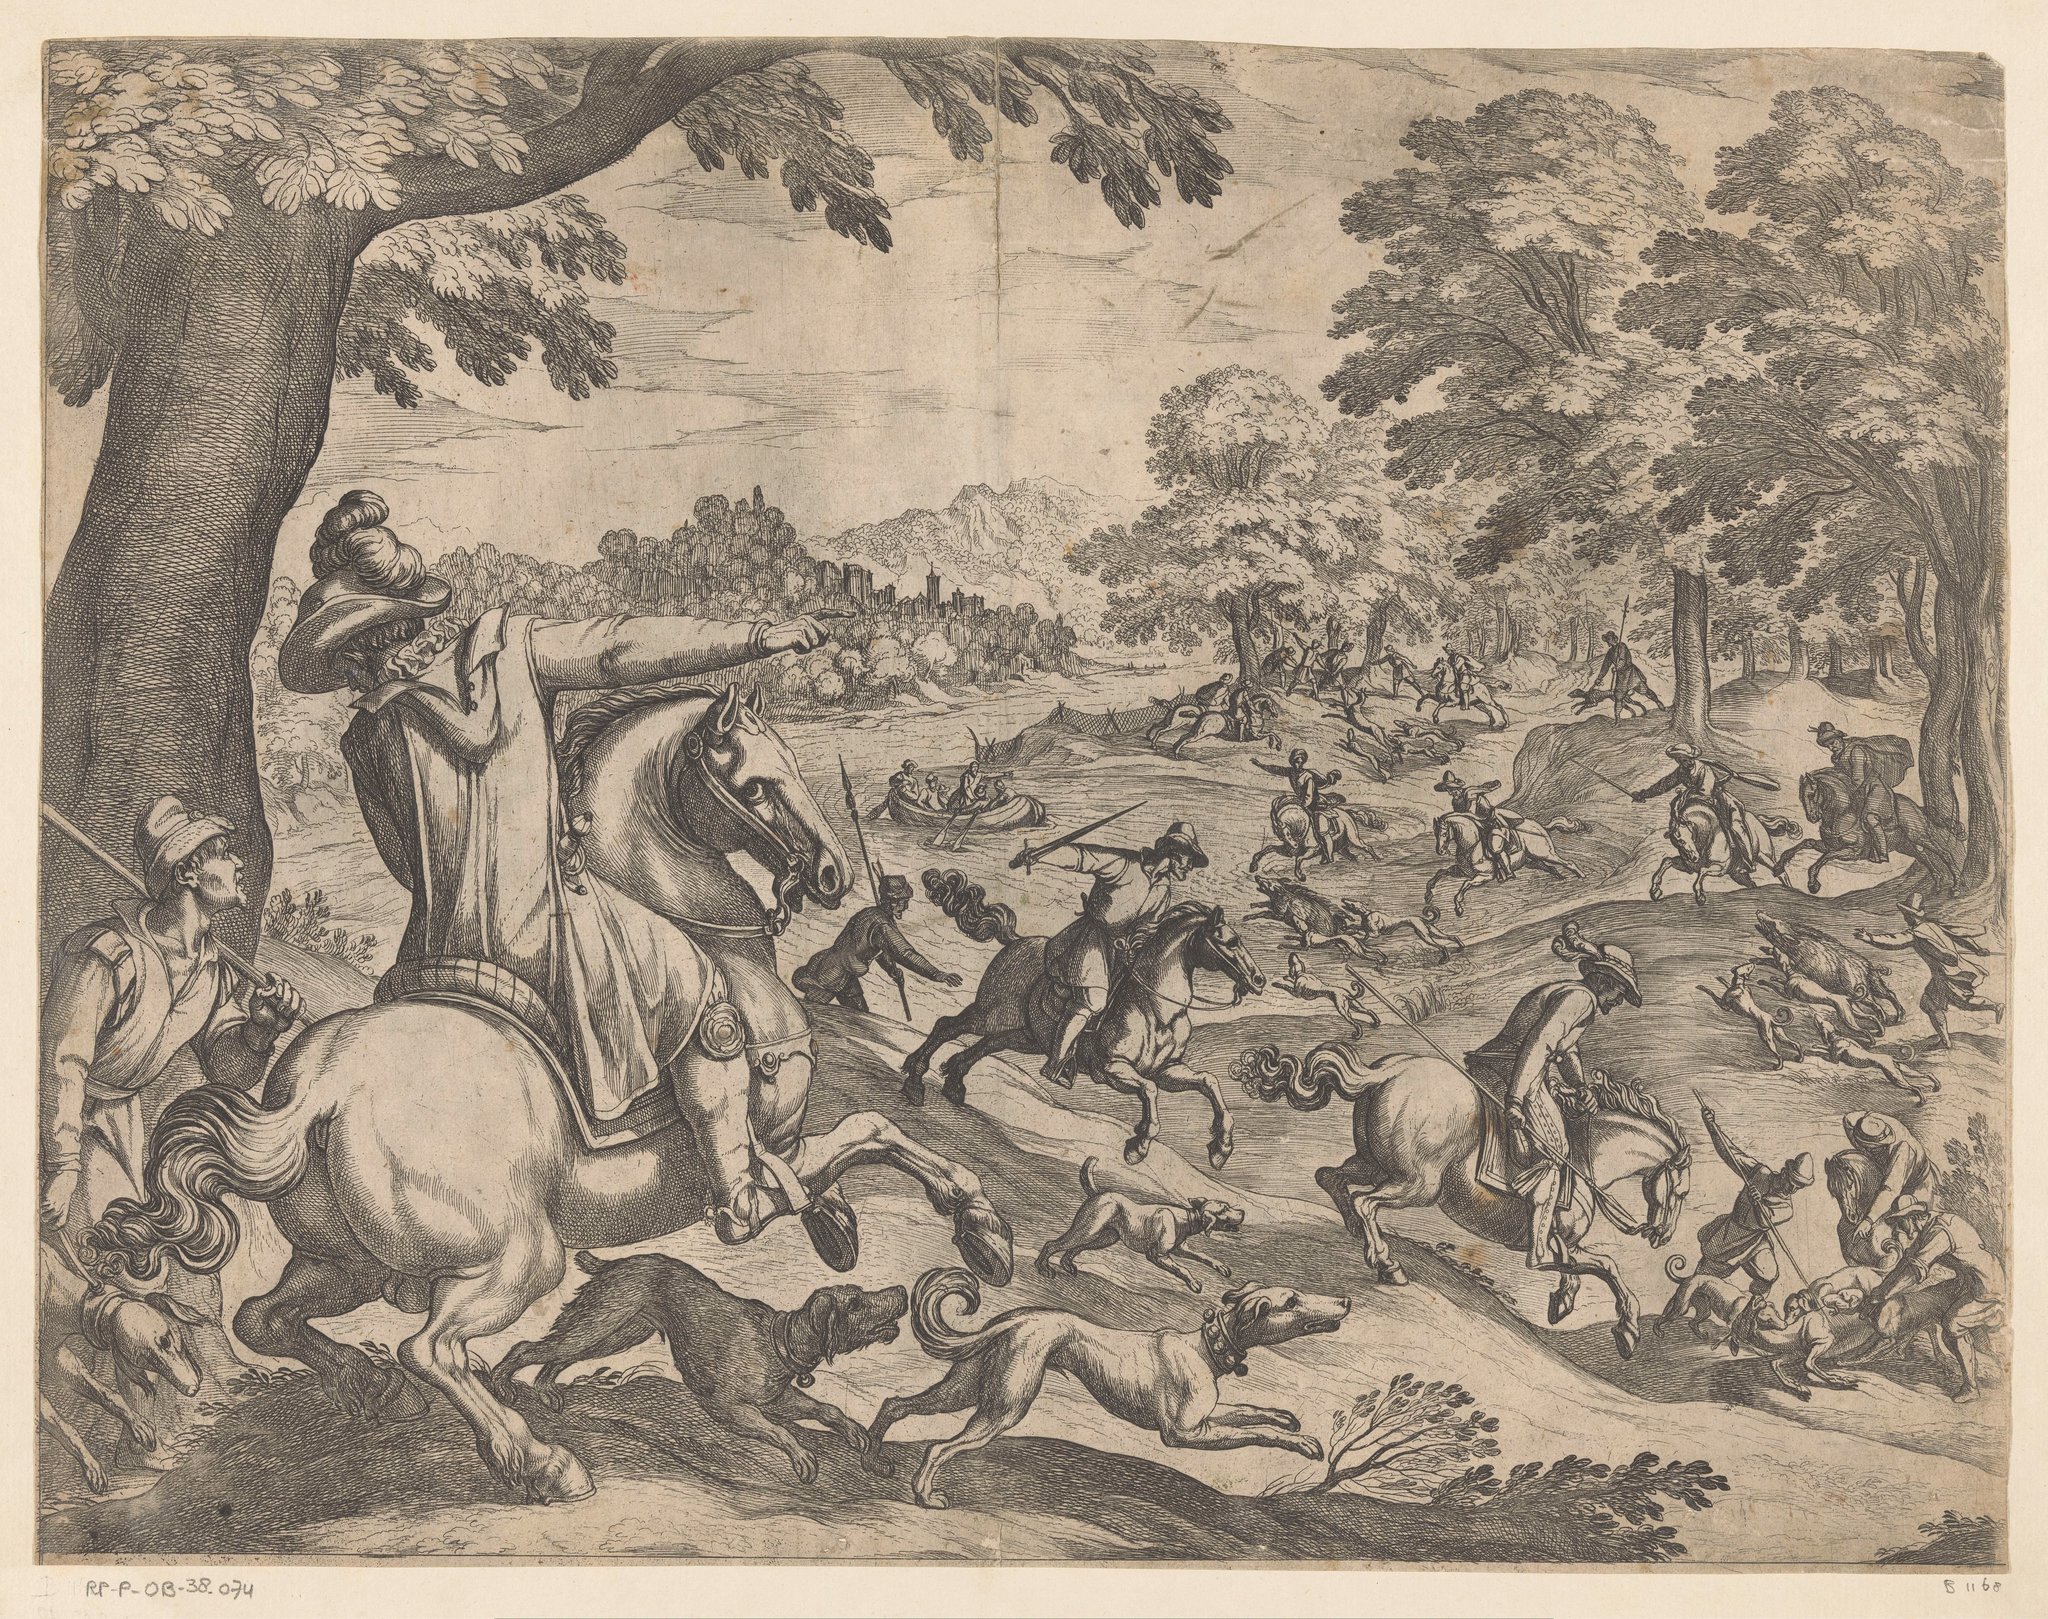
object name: print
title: Jacht op herten en everzwijnen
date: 1599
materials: paper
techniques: etching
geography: rome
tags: stag-hunting, boar-hunting, hunter, hunters hunting (n.b.: in 1988-1990 this notation denoted the concept of 43c11421 'hunters resting during the hunt')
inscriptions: collector's mark: Lugt 240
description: Deze prent maakt deel uit van een reeks van vijf prenten met jachttaferelen. Ondermarge met datering en uitgeversadres afgesneden.